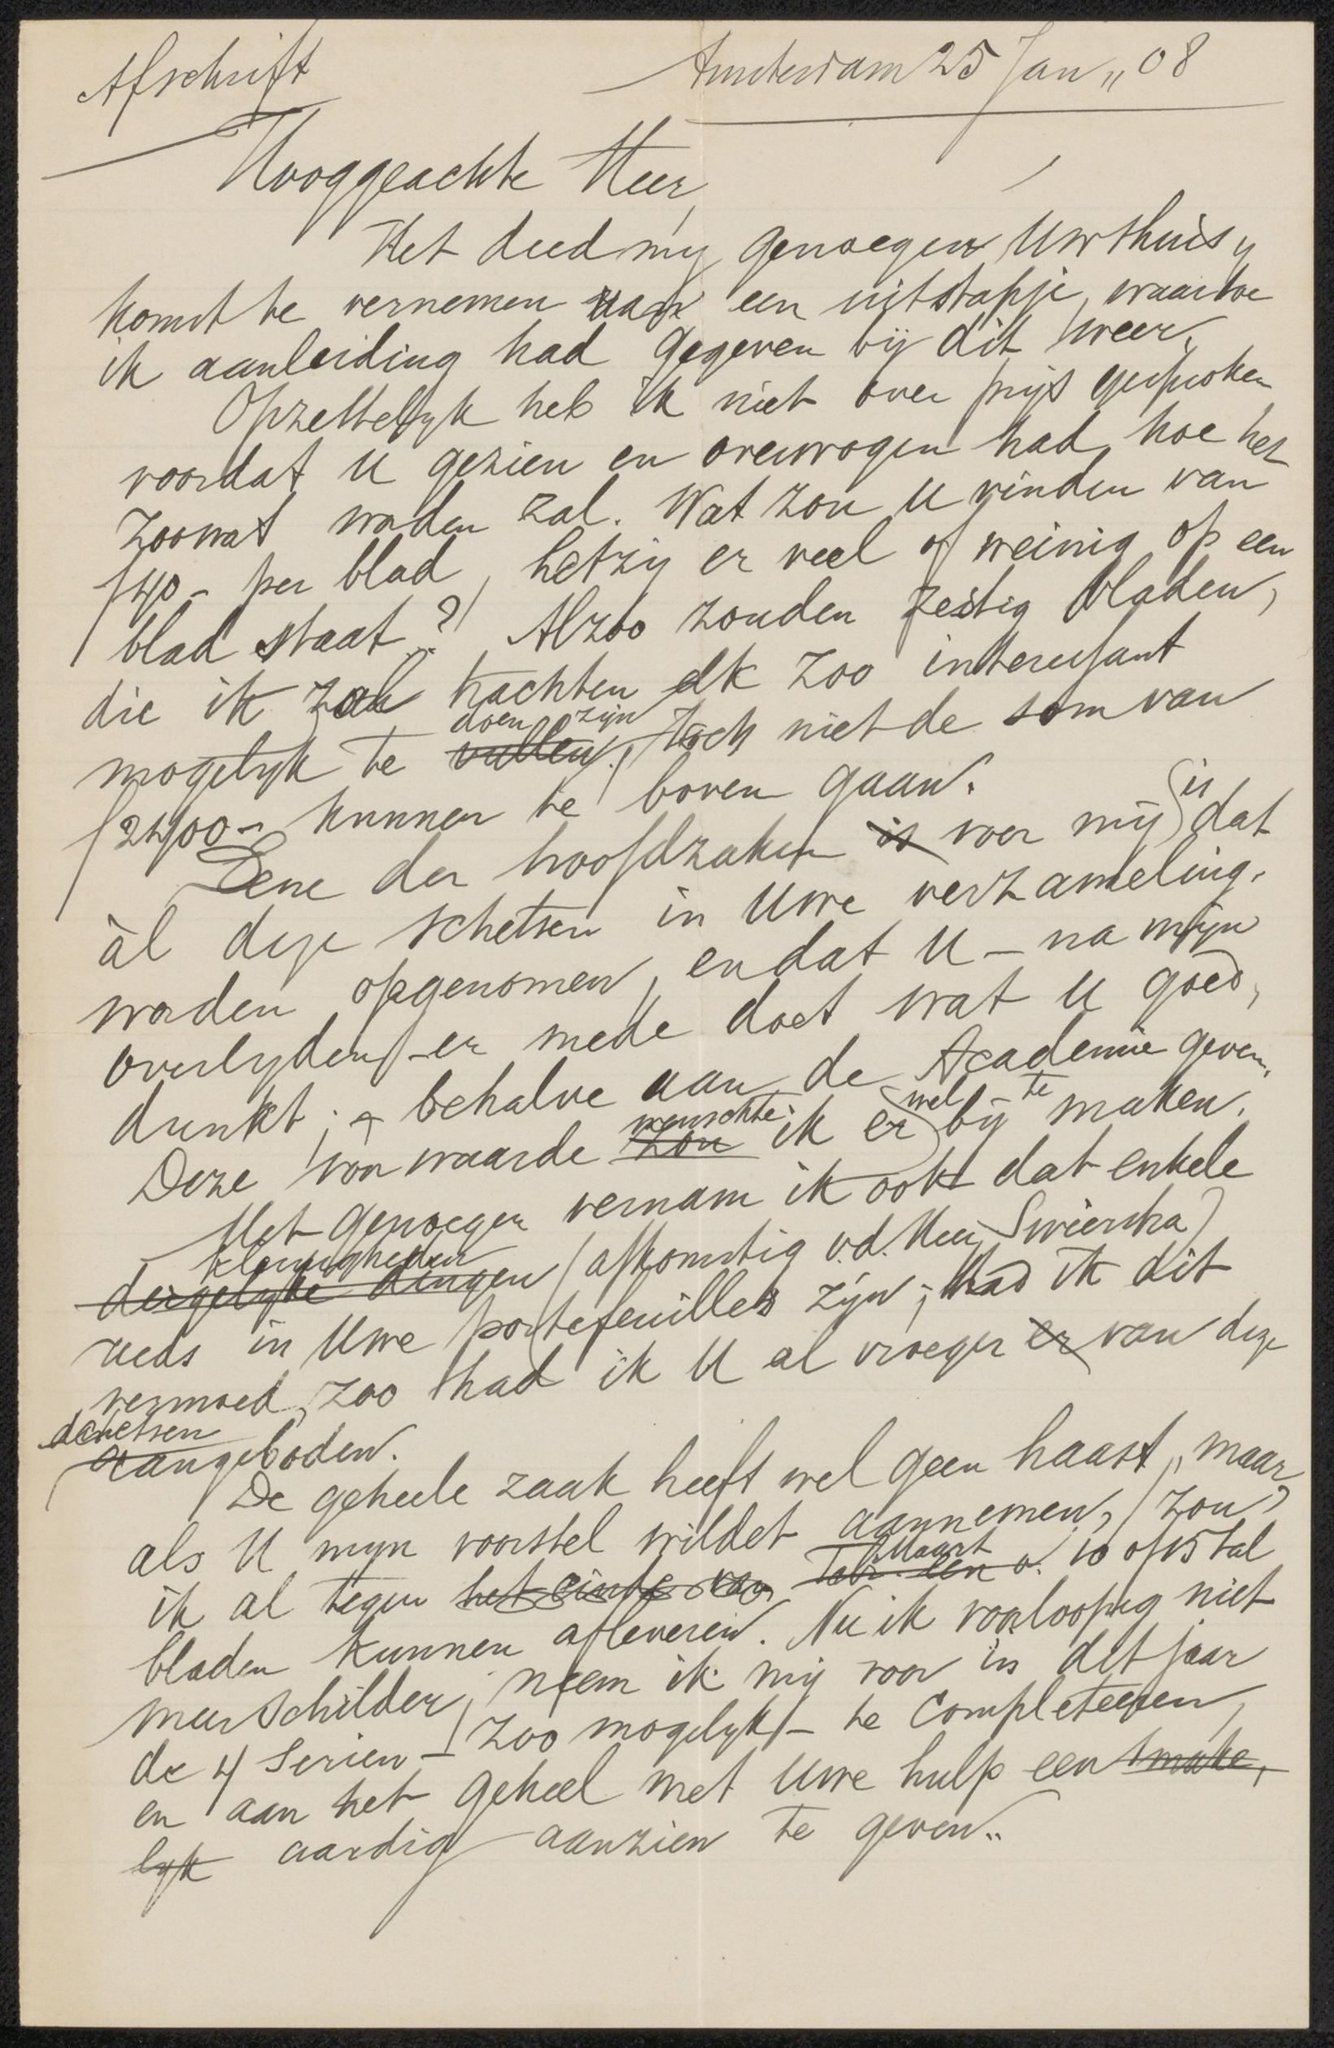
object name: letter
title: Brief aan anoniem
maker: august allebé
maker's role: draughtsman, print maker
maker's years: 1838-1927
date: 1908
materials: ink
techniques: pen, writing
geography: amsterdam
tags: art trade, art shop, drawing, money